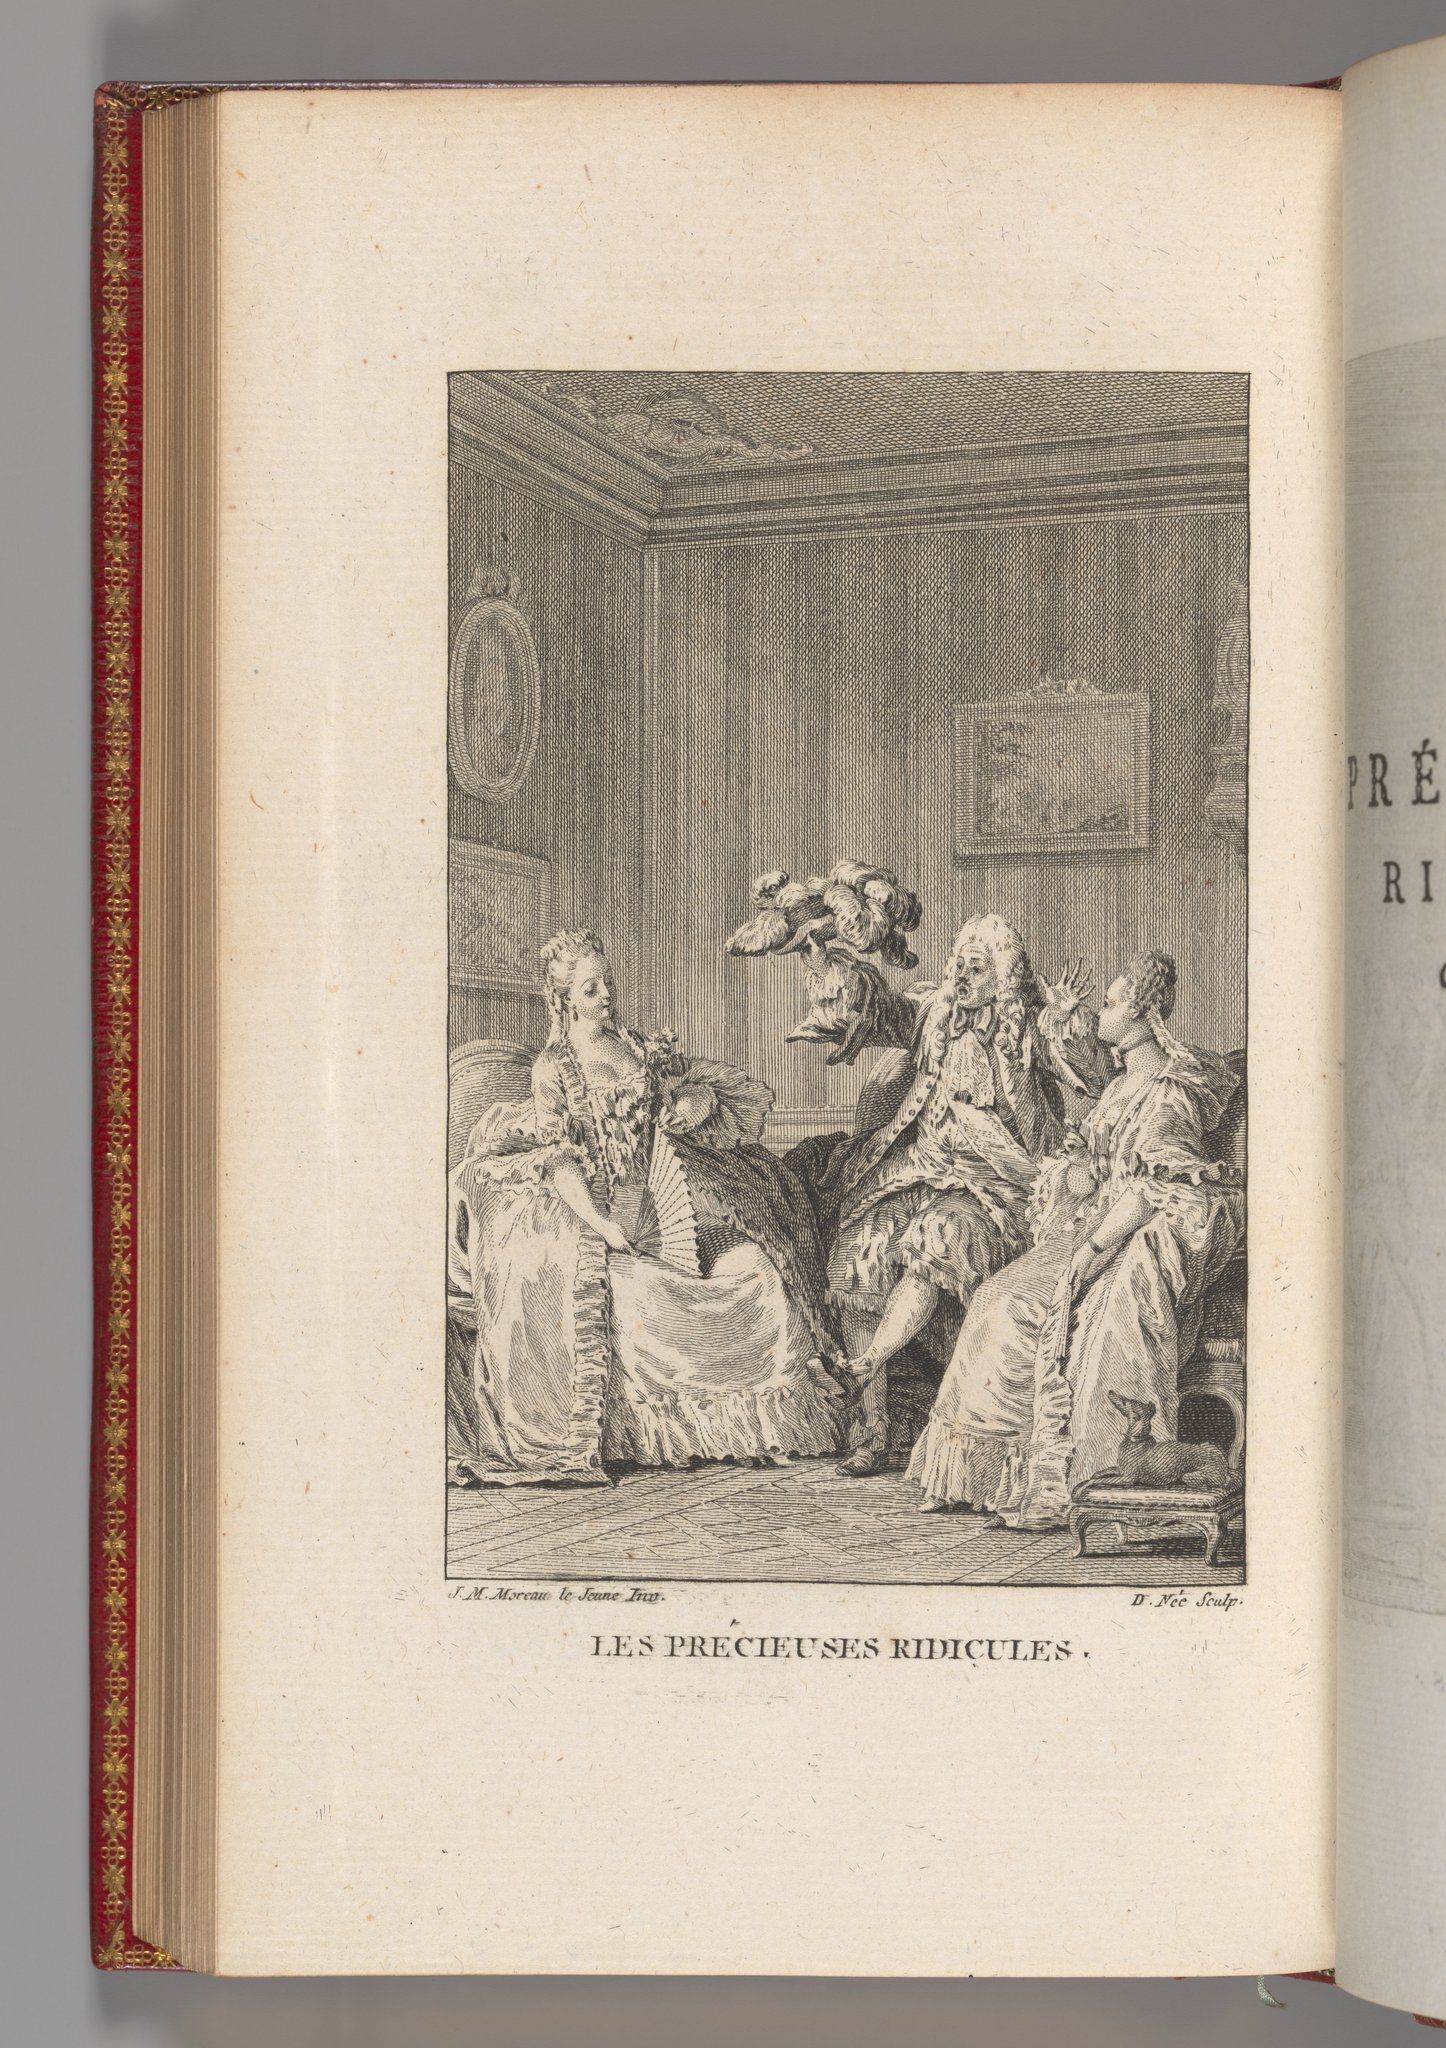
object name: book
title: Volume I of Oeuvres de Molière, avec des remarques grammaticales, des Avertissimens et des Observations sur chaque Pièce par M. Bret. A Paris, Par la Compagnie des libraires associés. M.D.CC.LXXIII.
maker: jean michel moreau le jeune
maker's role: artist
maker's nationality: french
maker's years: 1741-1814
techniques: engraving, etching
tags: men,women,dogs